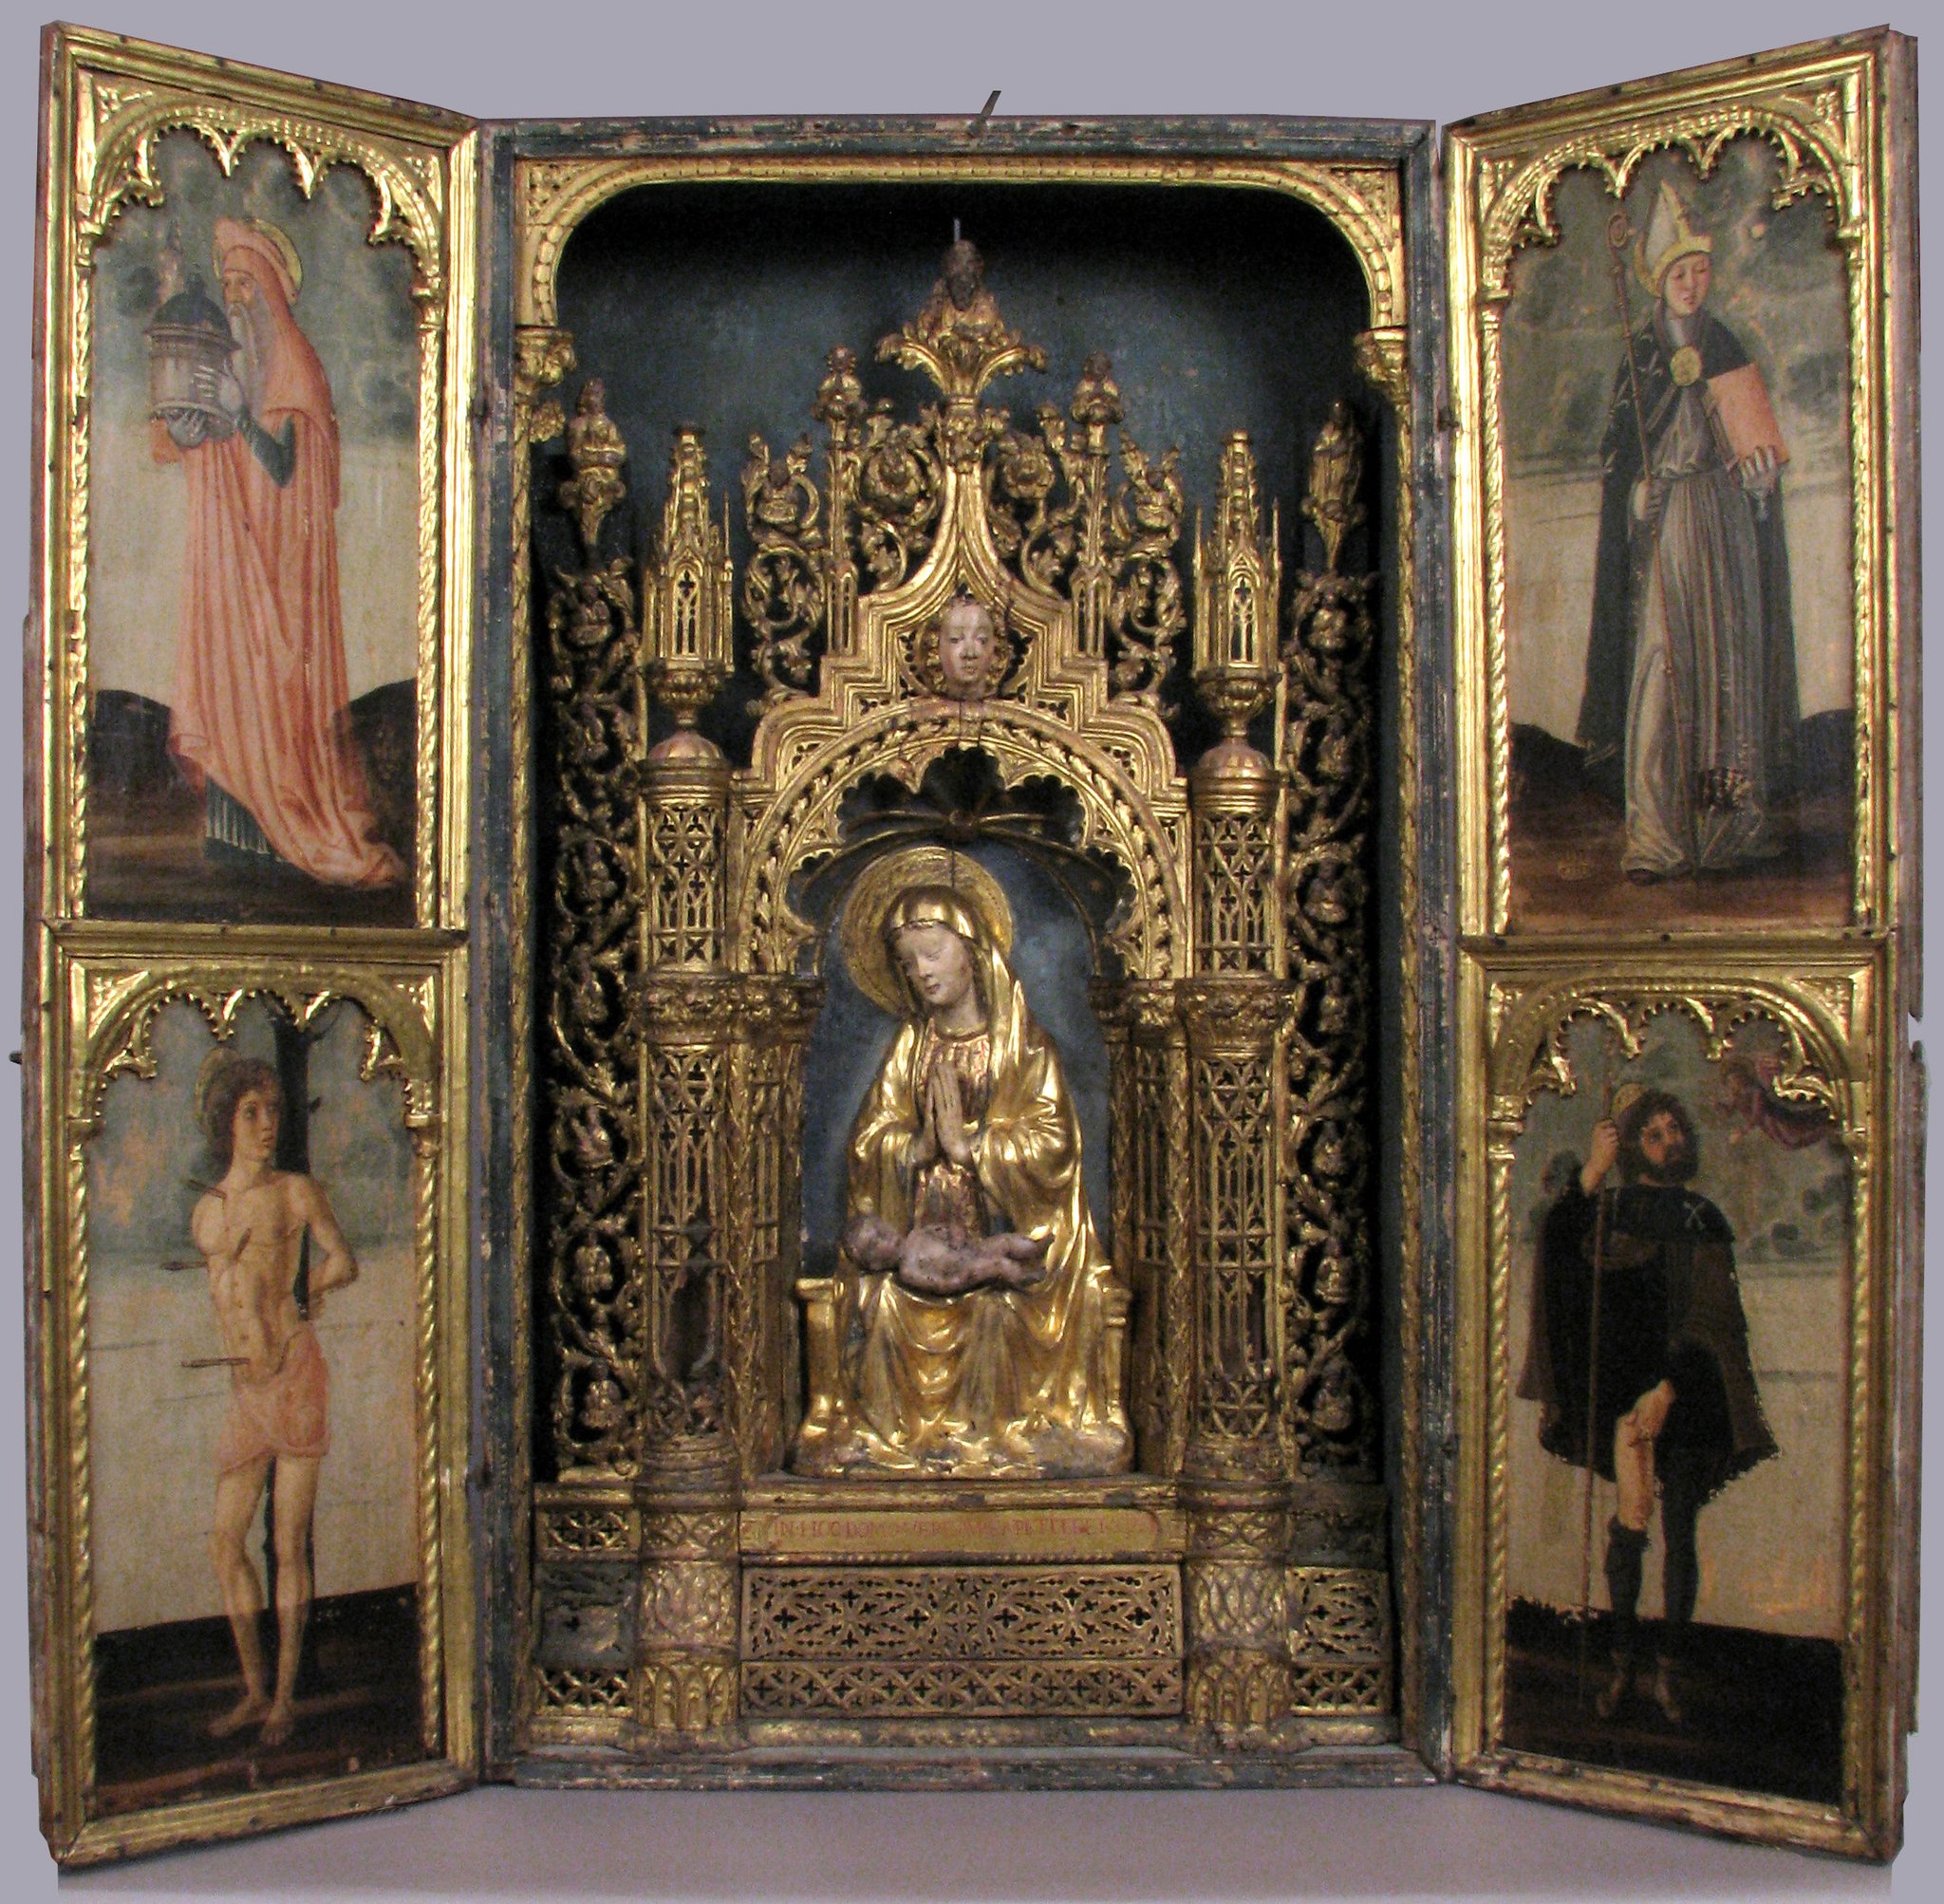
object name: shrine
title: Altar Shrine with Four Saints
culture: italian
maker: italian (venetian) painter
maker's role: artist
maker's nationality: italian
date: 1450-1475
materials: gold leaf, oil, panel, wood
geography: italy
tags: madonna and child,saint jerome,saints,saint sebastian